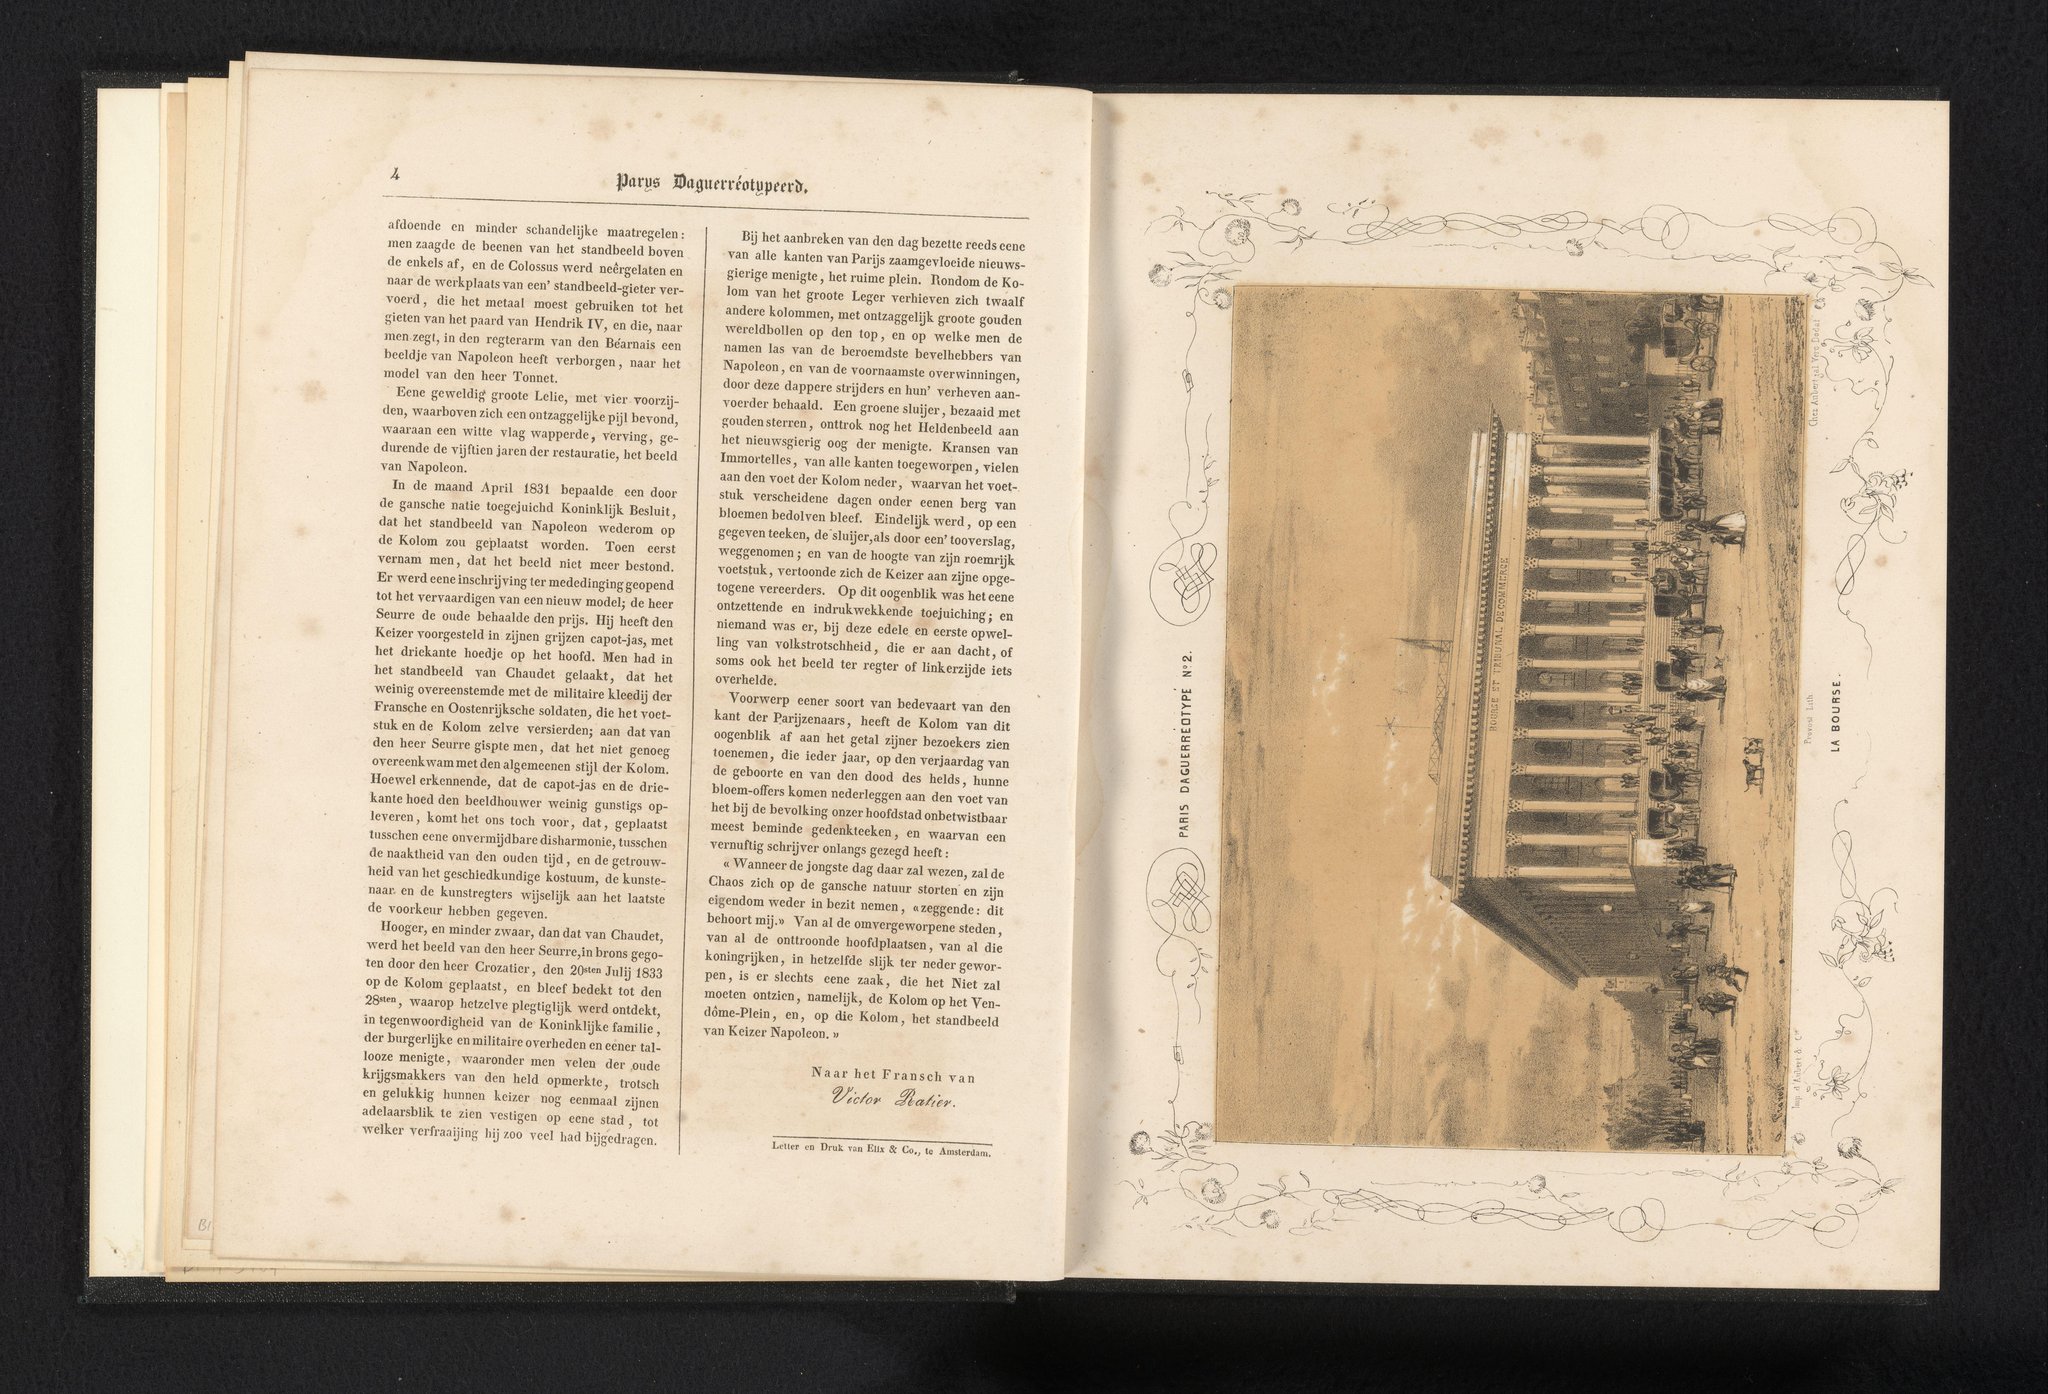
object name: page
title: Gezicht op het Palais Brongniart in Parijs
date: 1839-1840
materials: paper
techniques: tone lithography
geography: paris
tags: palace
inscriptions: inscription: ‘PARIS DAGUERRÉOTYPÉ No. 2.’